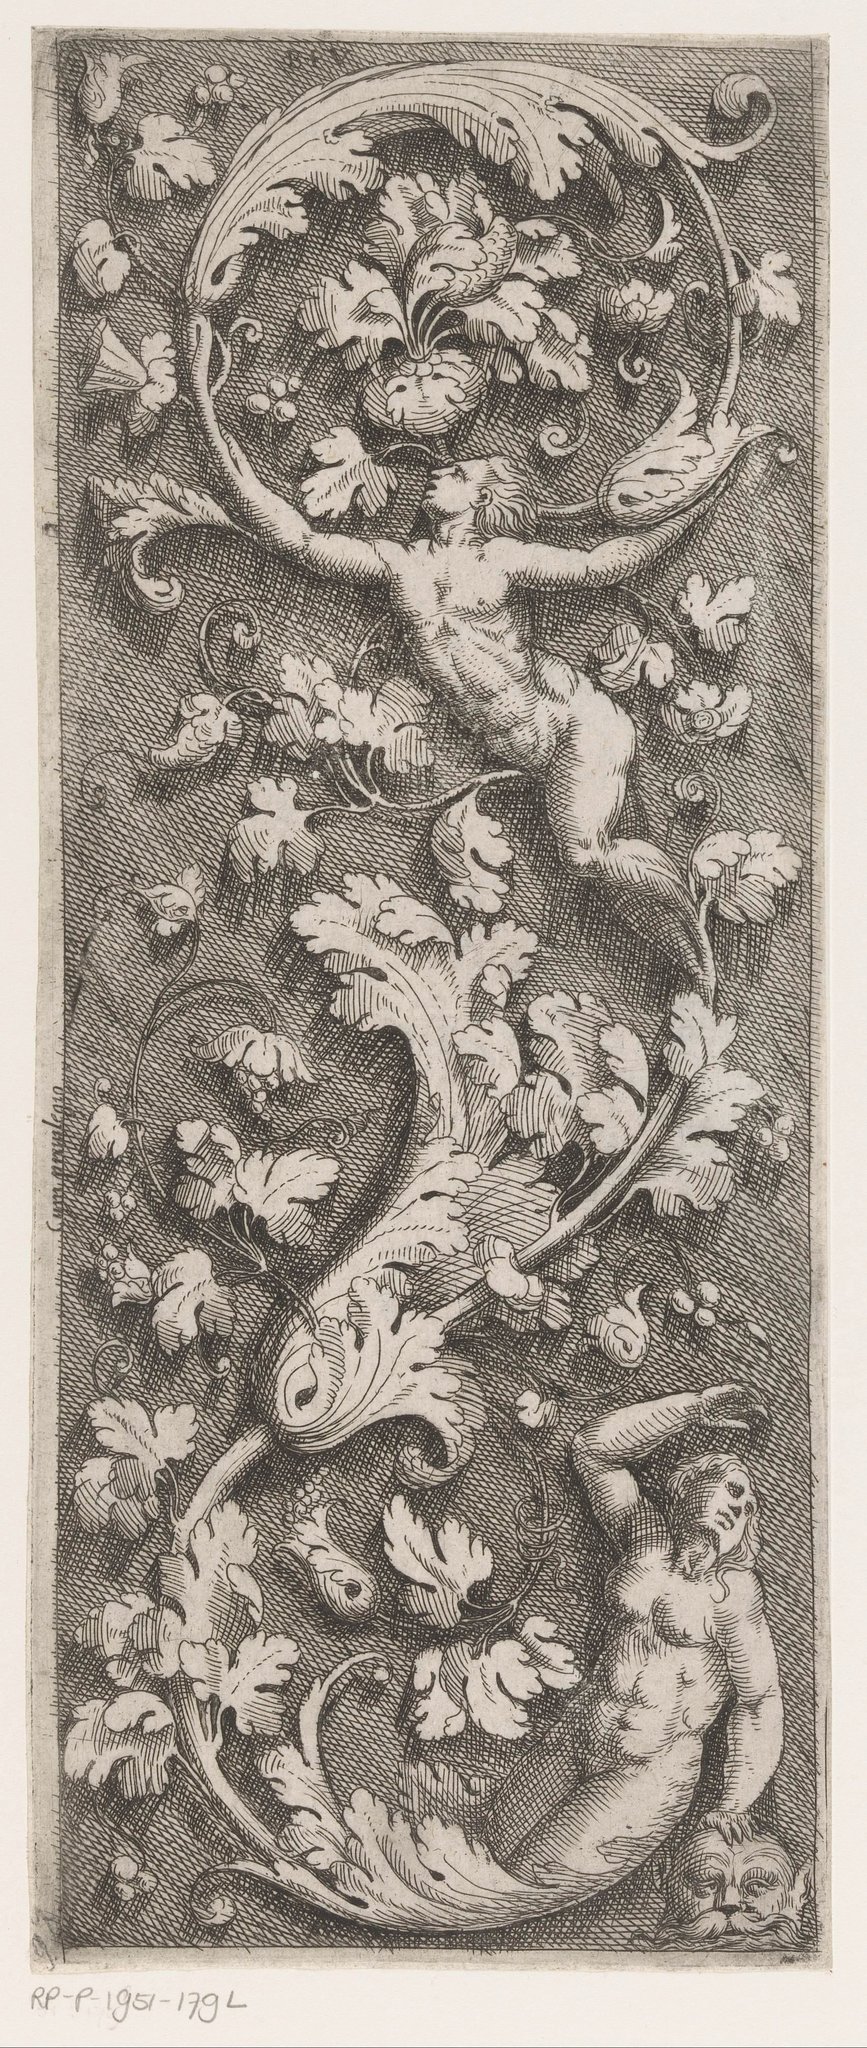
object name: ornament print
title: Ornamentele friezen met arabesken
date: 1561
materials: paper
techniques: etching, intaglio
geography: venice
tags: ornaments ~ art, foliage ~ ornament, the (nude) human figure; 'corpo humano' (ripa)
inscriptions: collector's mark: Lugt 2228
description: Deze prent maakt onderdeel uit van een reeks.